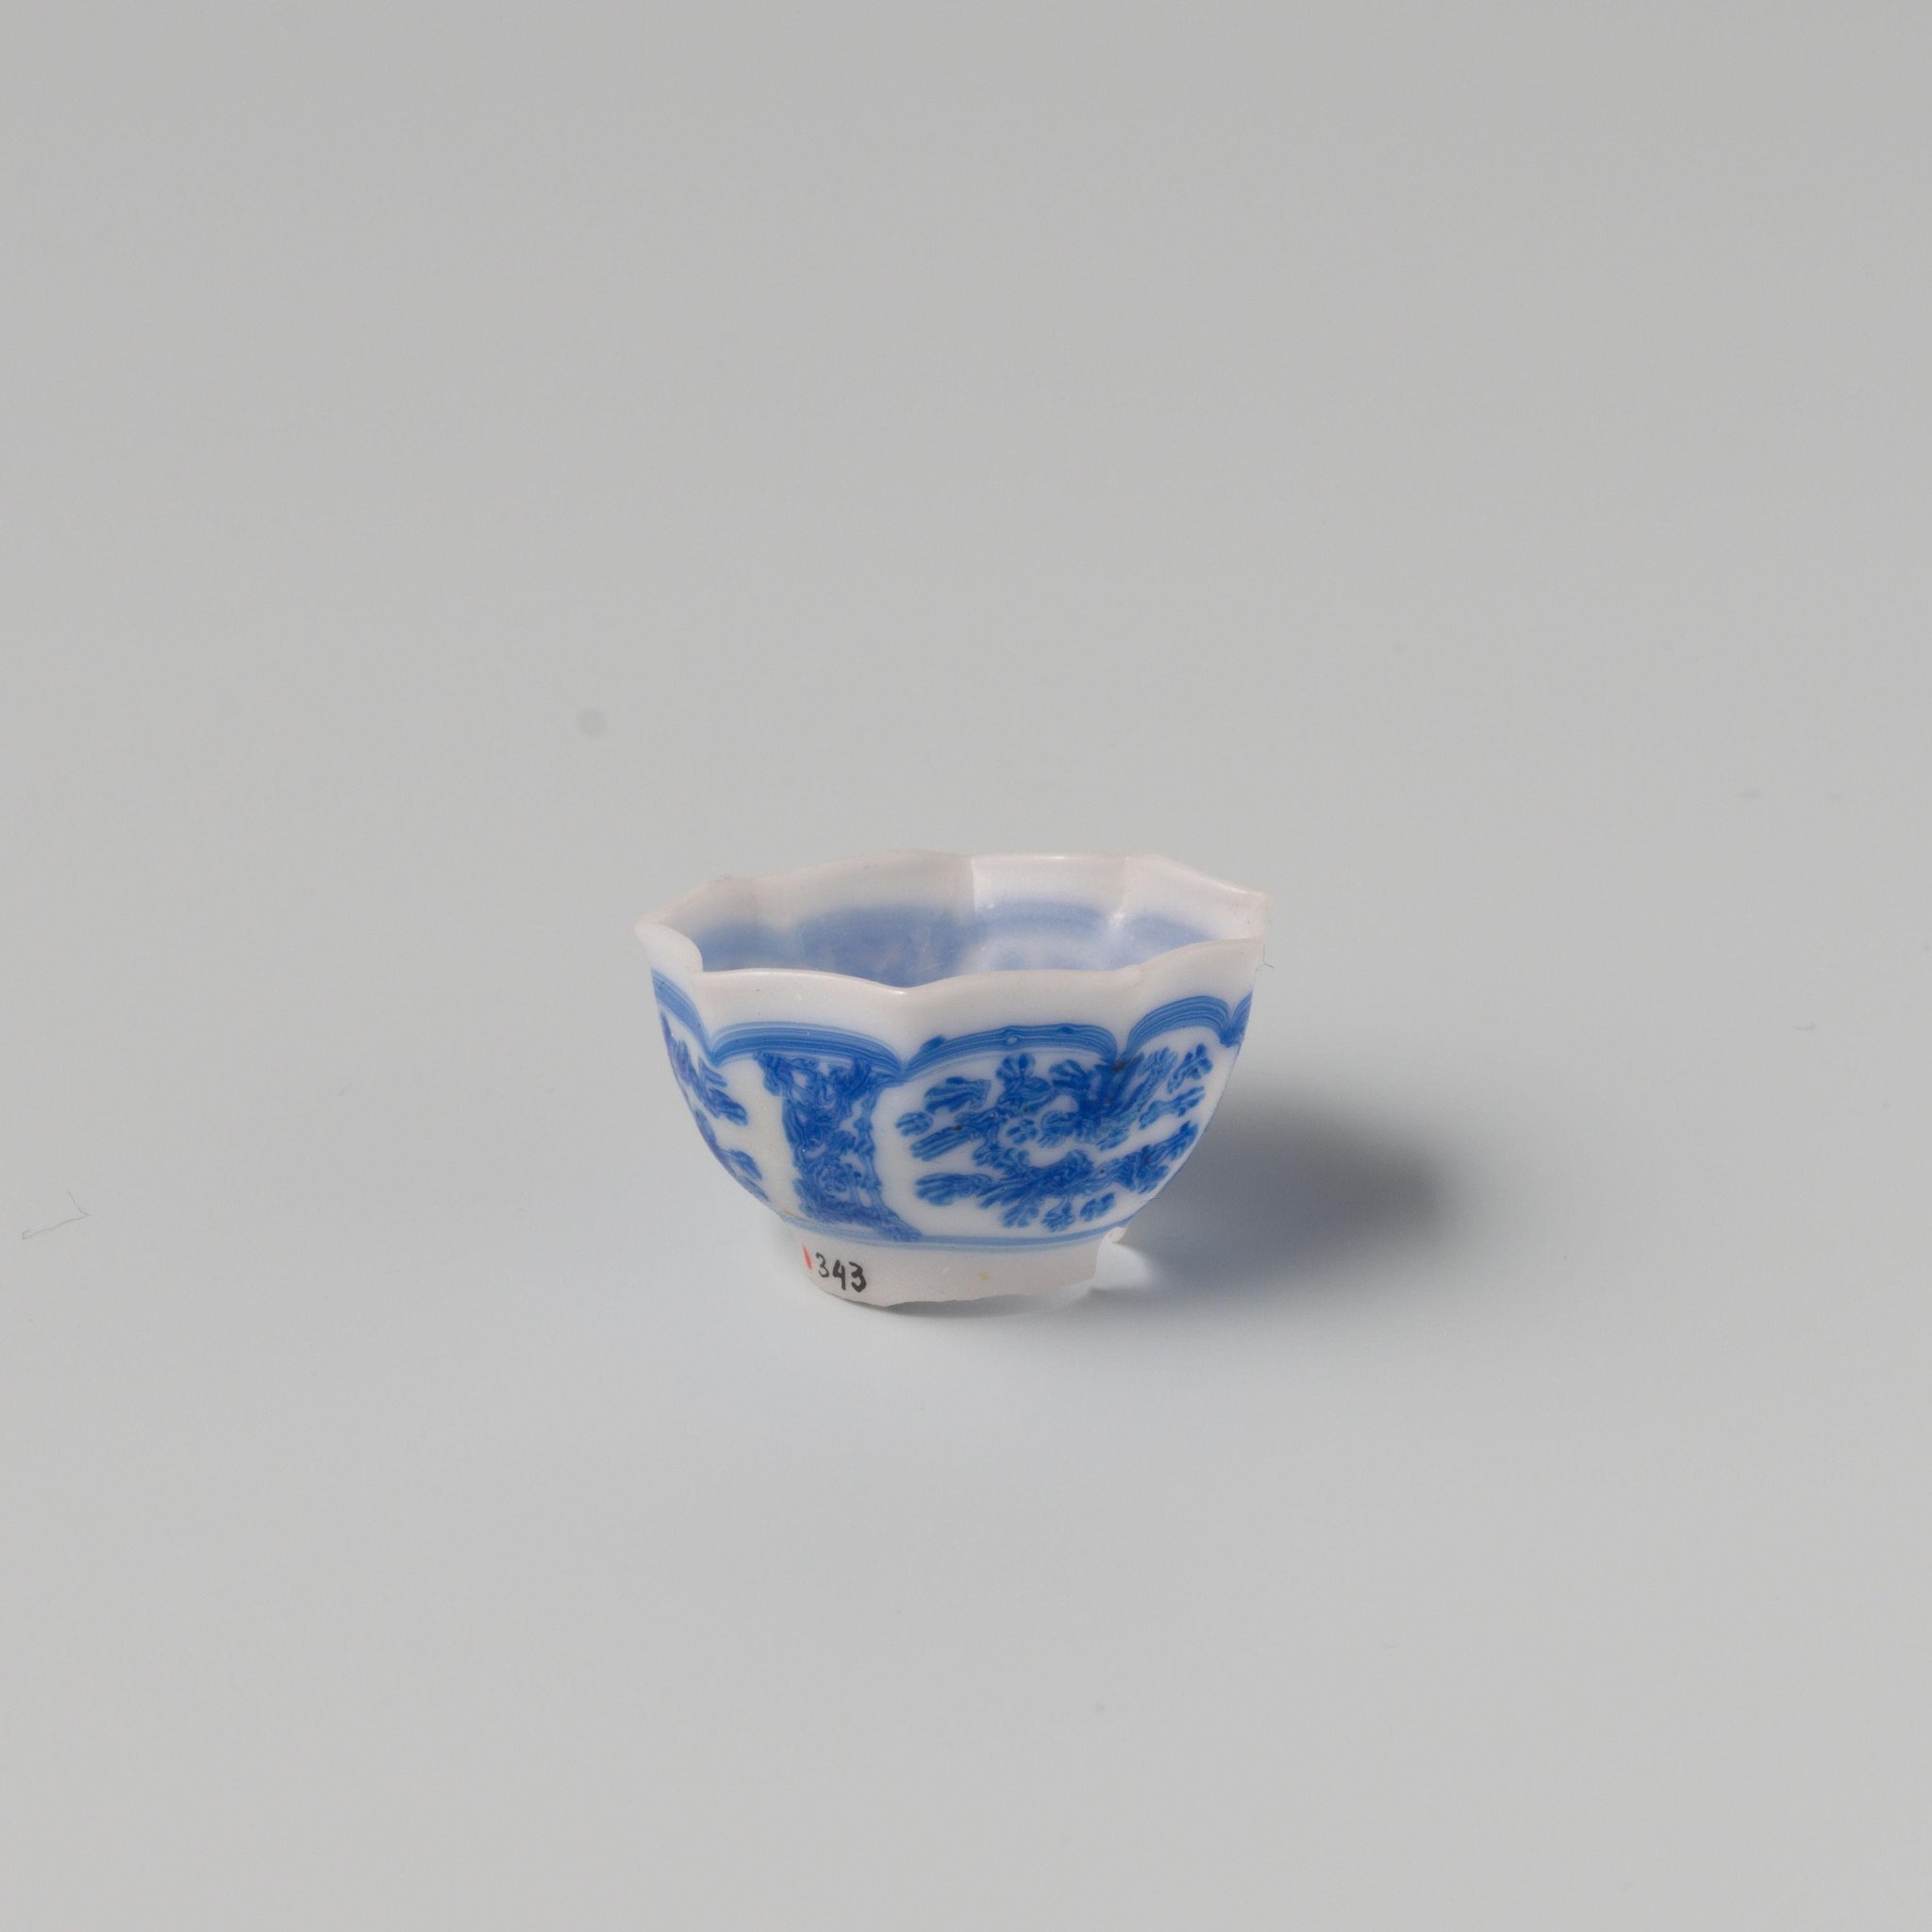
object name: slop bowl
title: Spoelkom van melkglas met blauwe emailverf beschildering, imitatie Chinees porselein; bloemmotieven in 3 vakken in Kraakporselein stijl. Negen punten samen geknepen rand.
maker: Anonymous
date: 1675-1710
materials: glass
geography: amsterdam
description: Spoelkom van melkglas met blauwe emailverf beschildering, imitatie Chinees blauw porselein; decoratie van bloemmotieven in drie vakkenin kraakporselein stijl. De in negen punten samen geknepen rand imiteert een veelkleurige kom. De bodem ontbreekt.